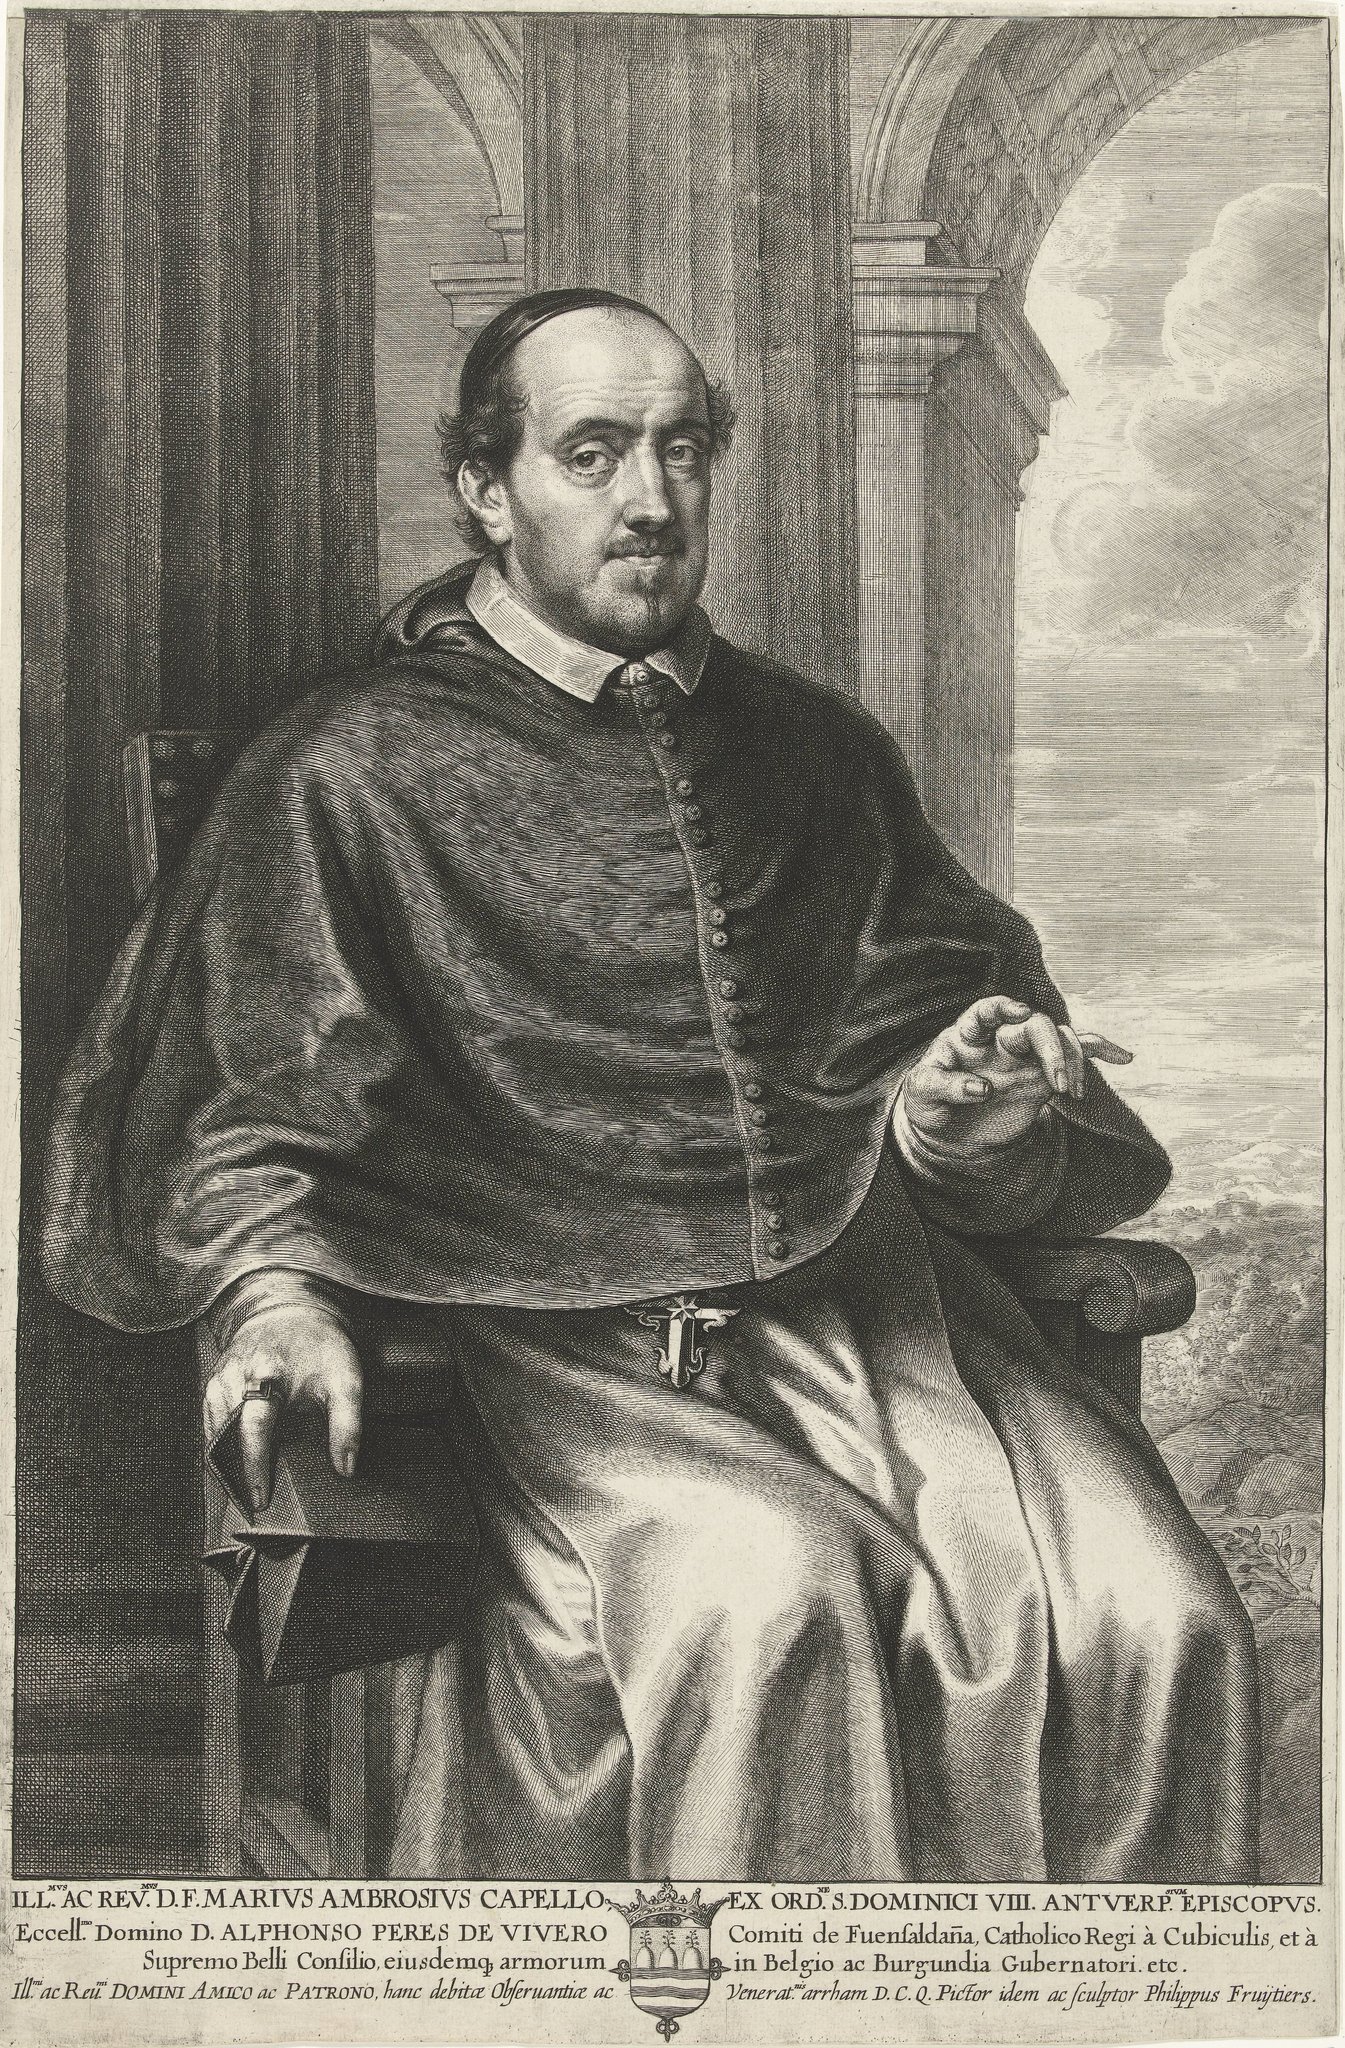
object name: print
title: Portret van Marius Ambrosius Capello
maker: philip fruytiers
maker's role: print maker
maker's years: 1610-1666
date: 1620-1666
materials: paper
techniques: etching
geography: antwerp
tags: antwerp, marius ambrosius capello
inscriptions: collector's mark: Lugt 2228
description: De bisschop van leper, Marius Ambrosius Capello, zittend in een stoel. Kniestuk. Hij houdt in zijn rechterhand een bisschopsmuts vast, zijn hoofd is getooid met een kalot. In de marge onder het portret staat een vierregelige tekst in het Latijn met in het midden een gekroond wapenschild.